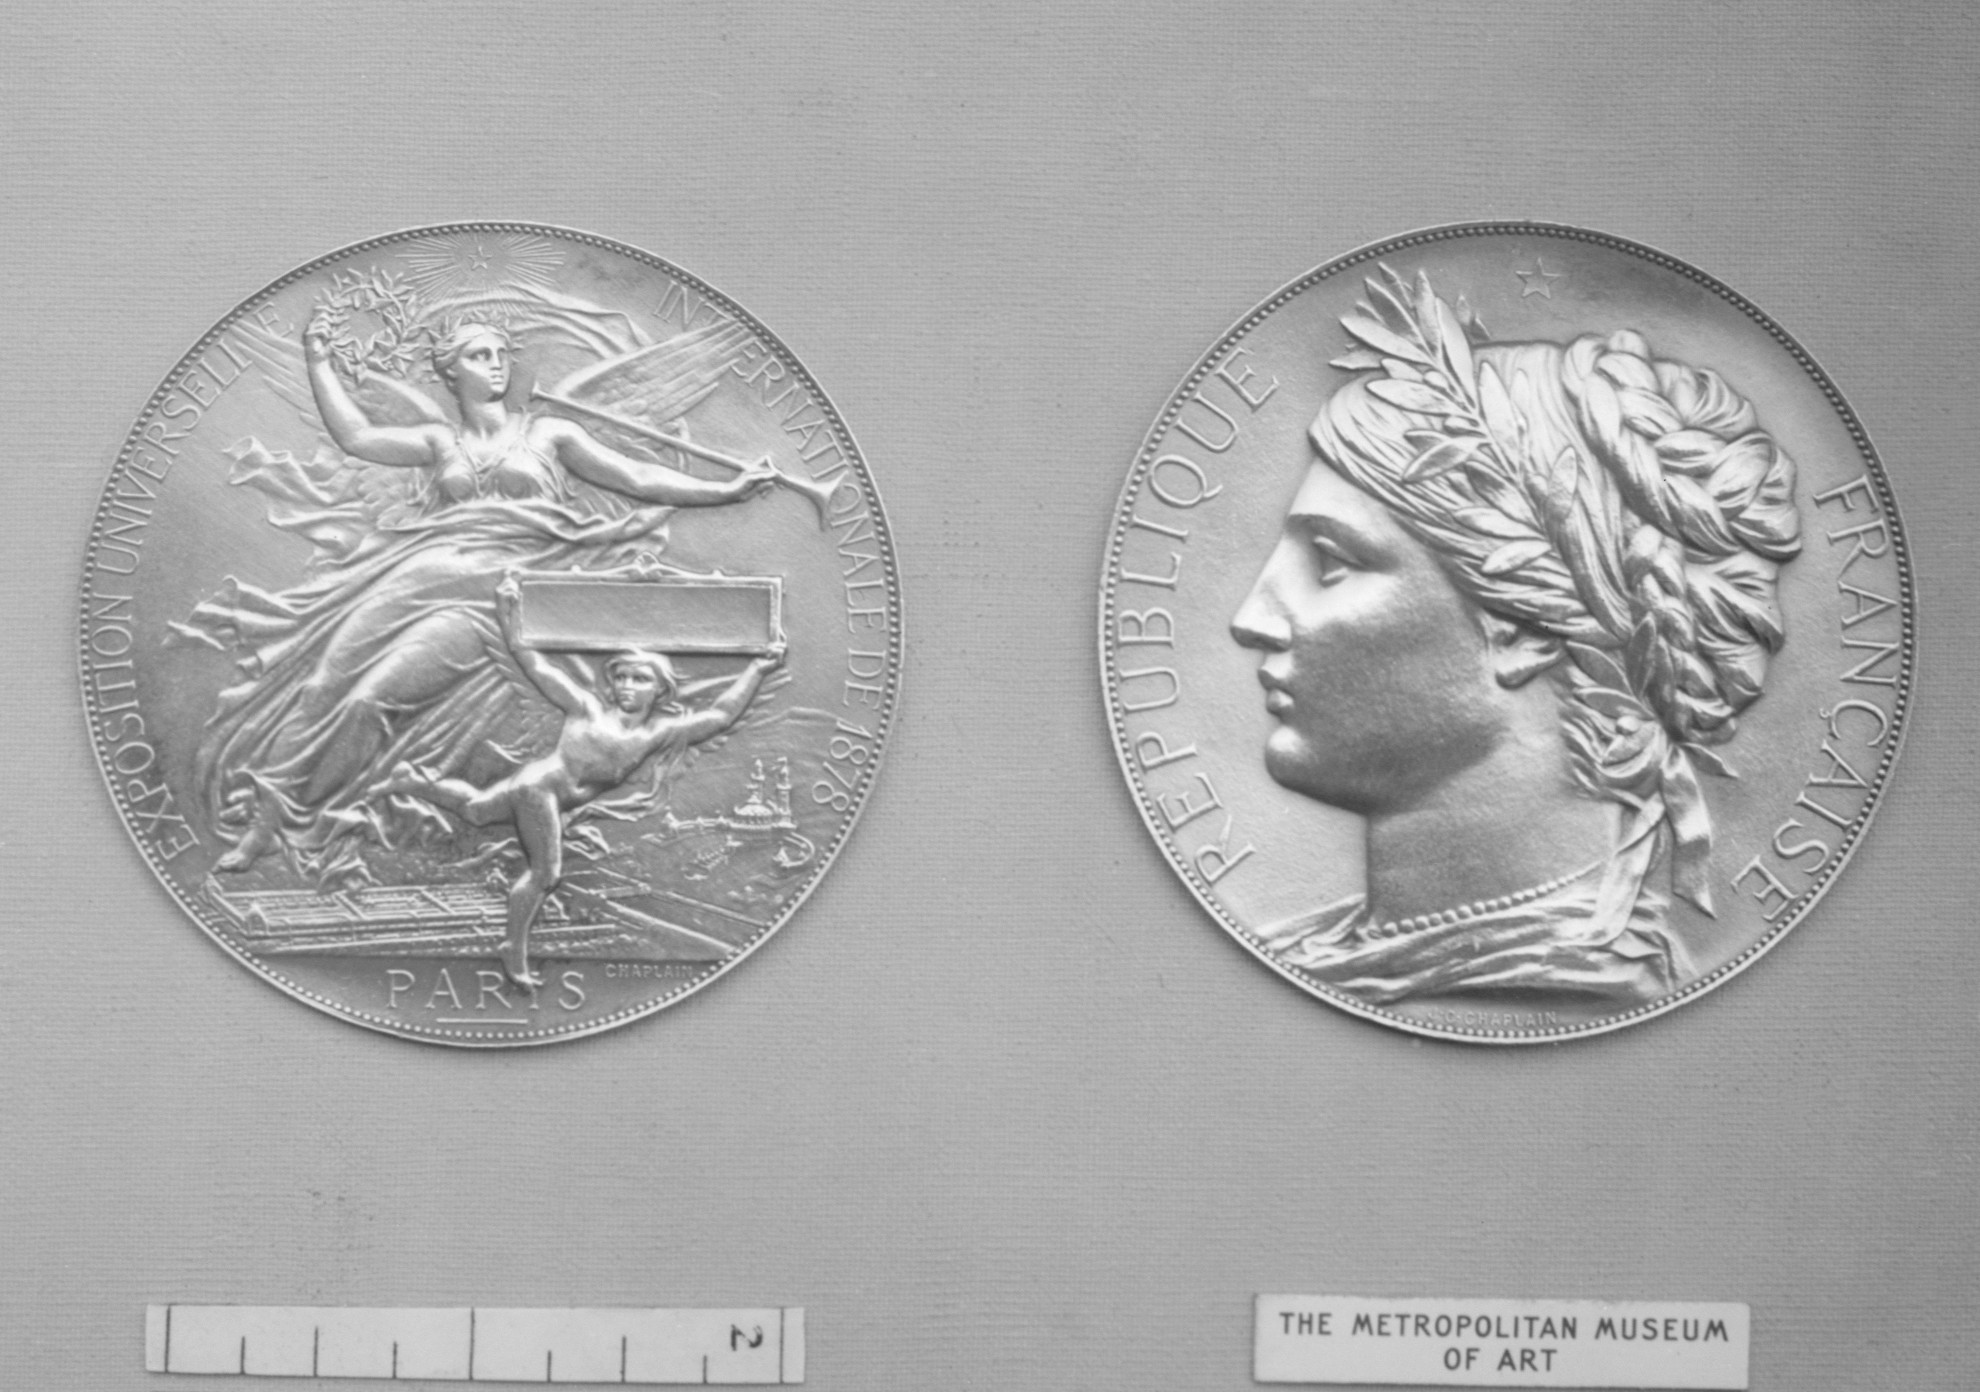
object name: medal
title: To Commemorate the Paris International Exposition of 1878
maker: jules-clément chaplain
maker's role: artist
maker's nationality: french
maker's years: 1839-1909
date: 1878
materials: bronze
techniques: silvered, struck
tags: profiles,women,angels